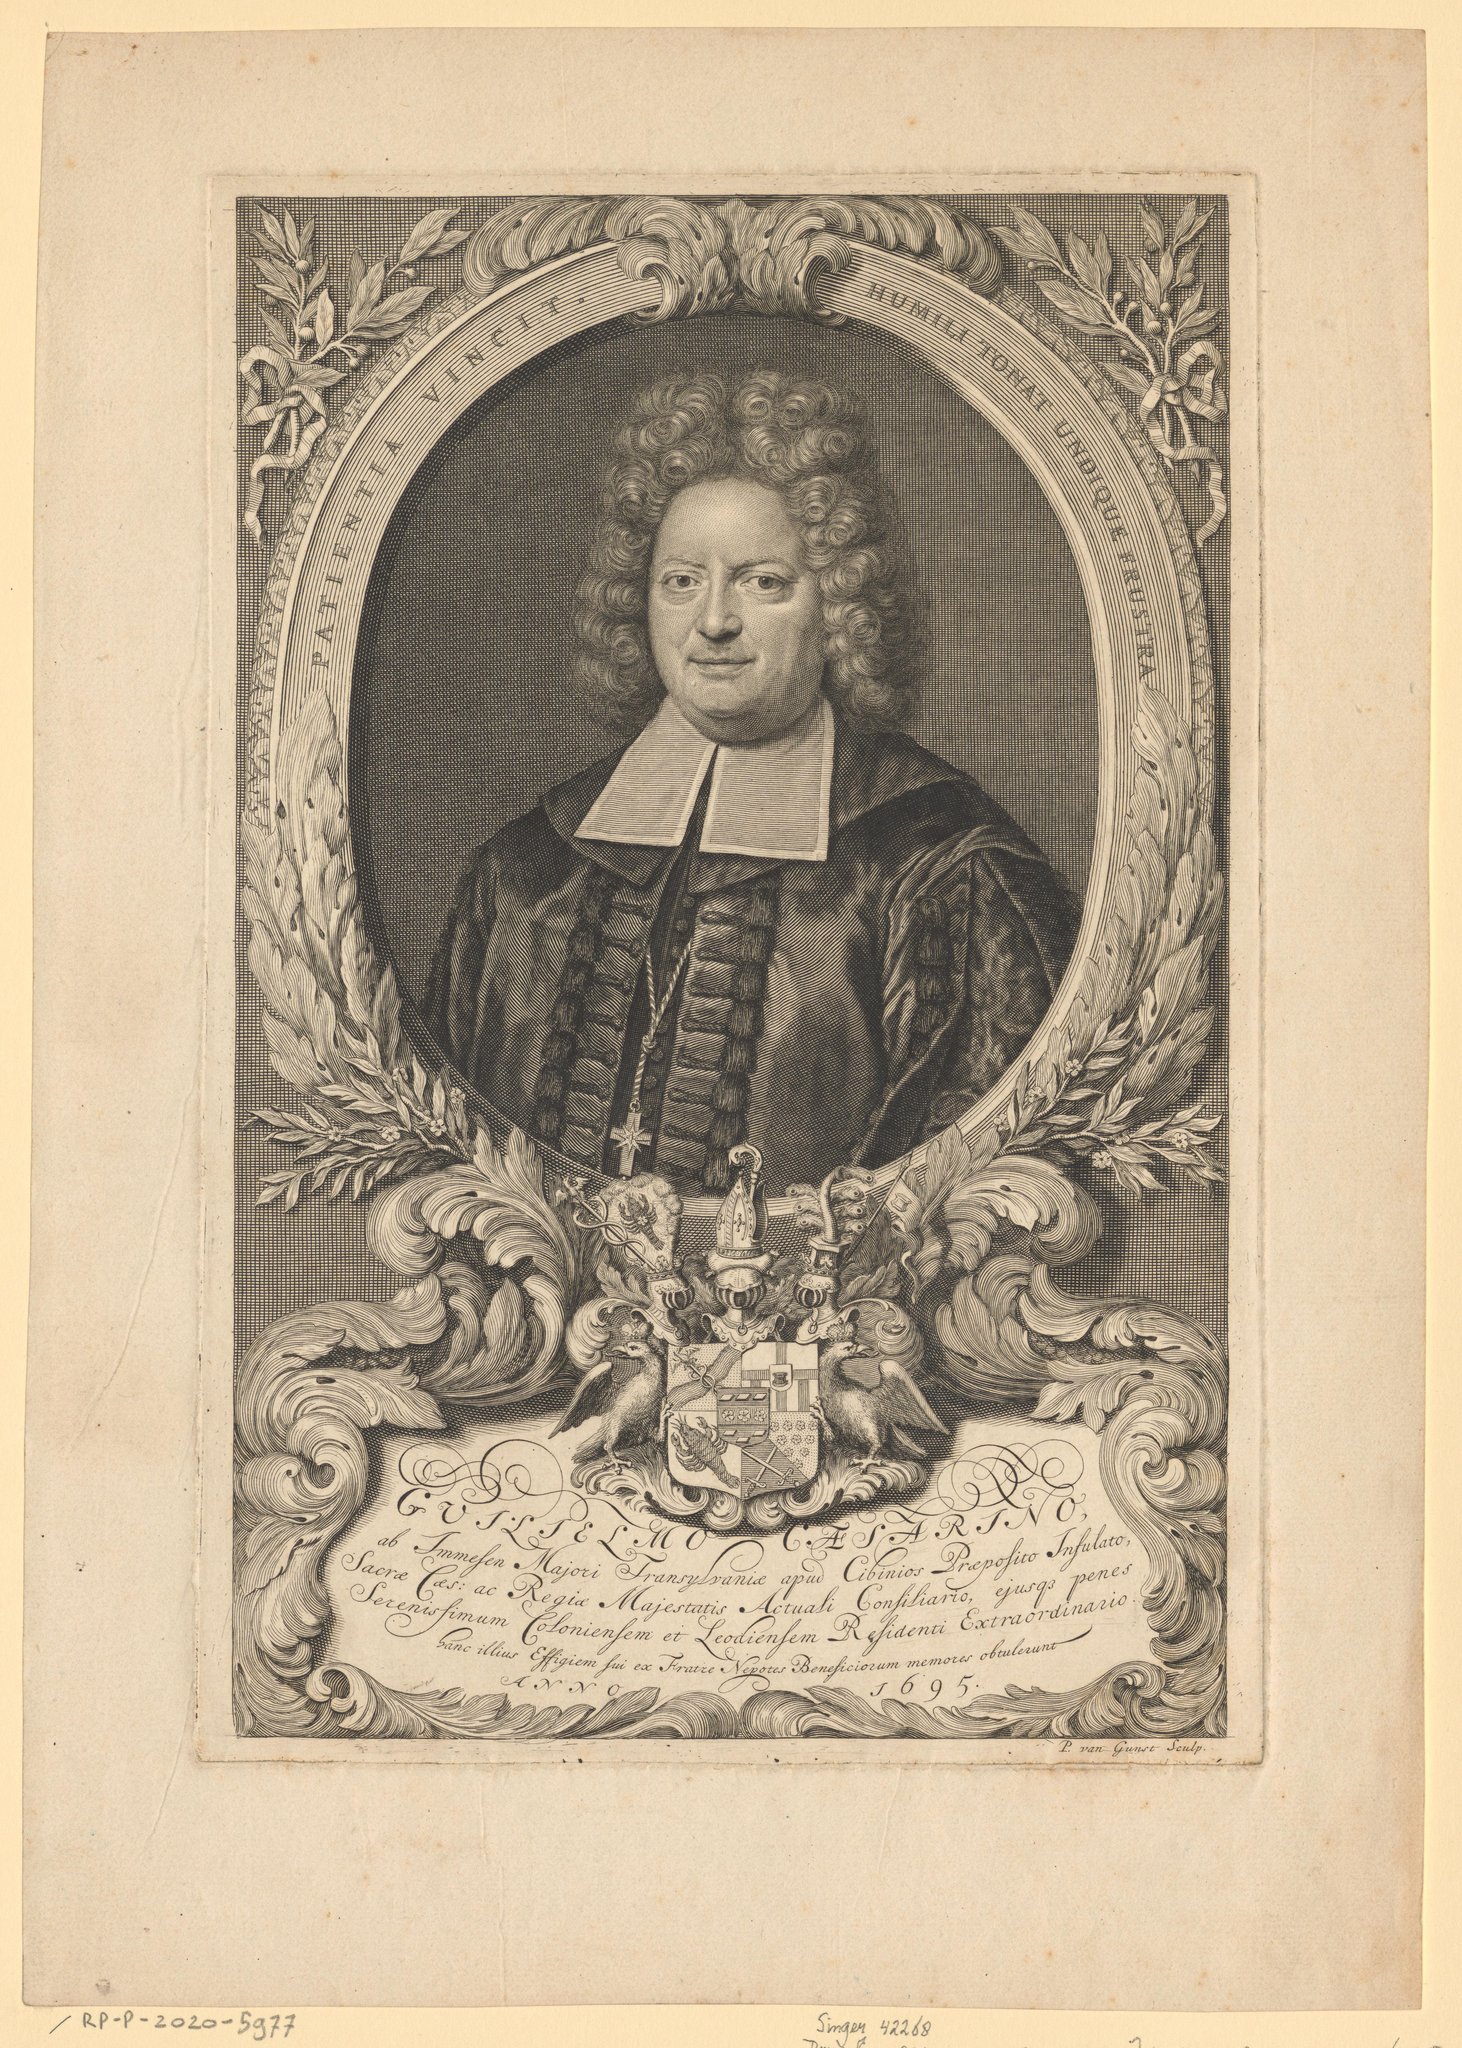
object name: print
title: Portret van Wilhelm Caesar Immesen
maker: pieter van gunst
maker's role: print maker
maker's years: 1658-1731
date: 1695-1731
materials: paper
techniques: engraving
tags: official; civil servant; functionary (in general), historical persons, armorial bearing, heraldry